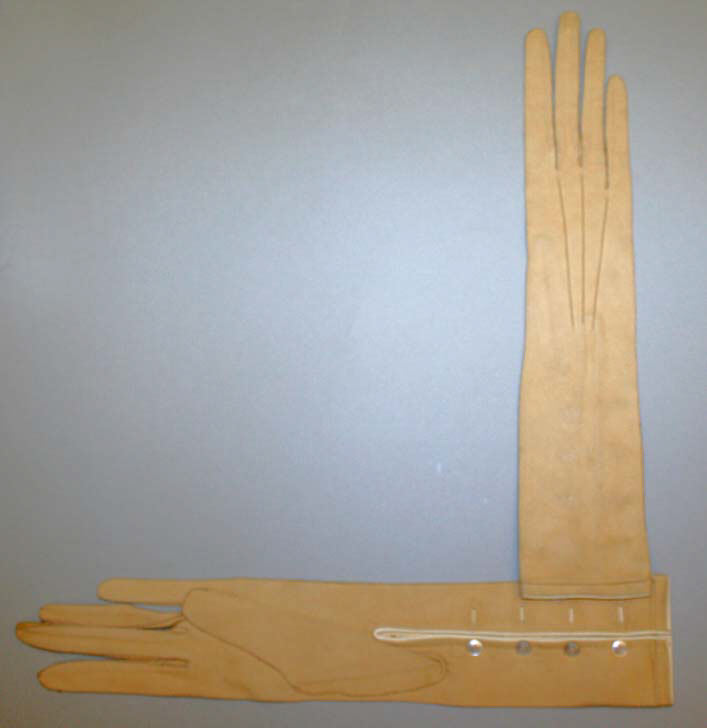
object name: glove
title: Gloves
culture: french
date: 1870-1889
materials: leather